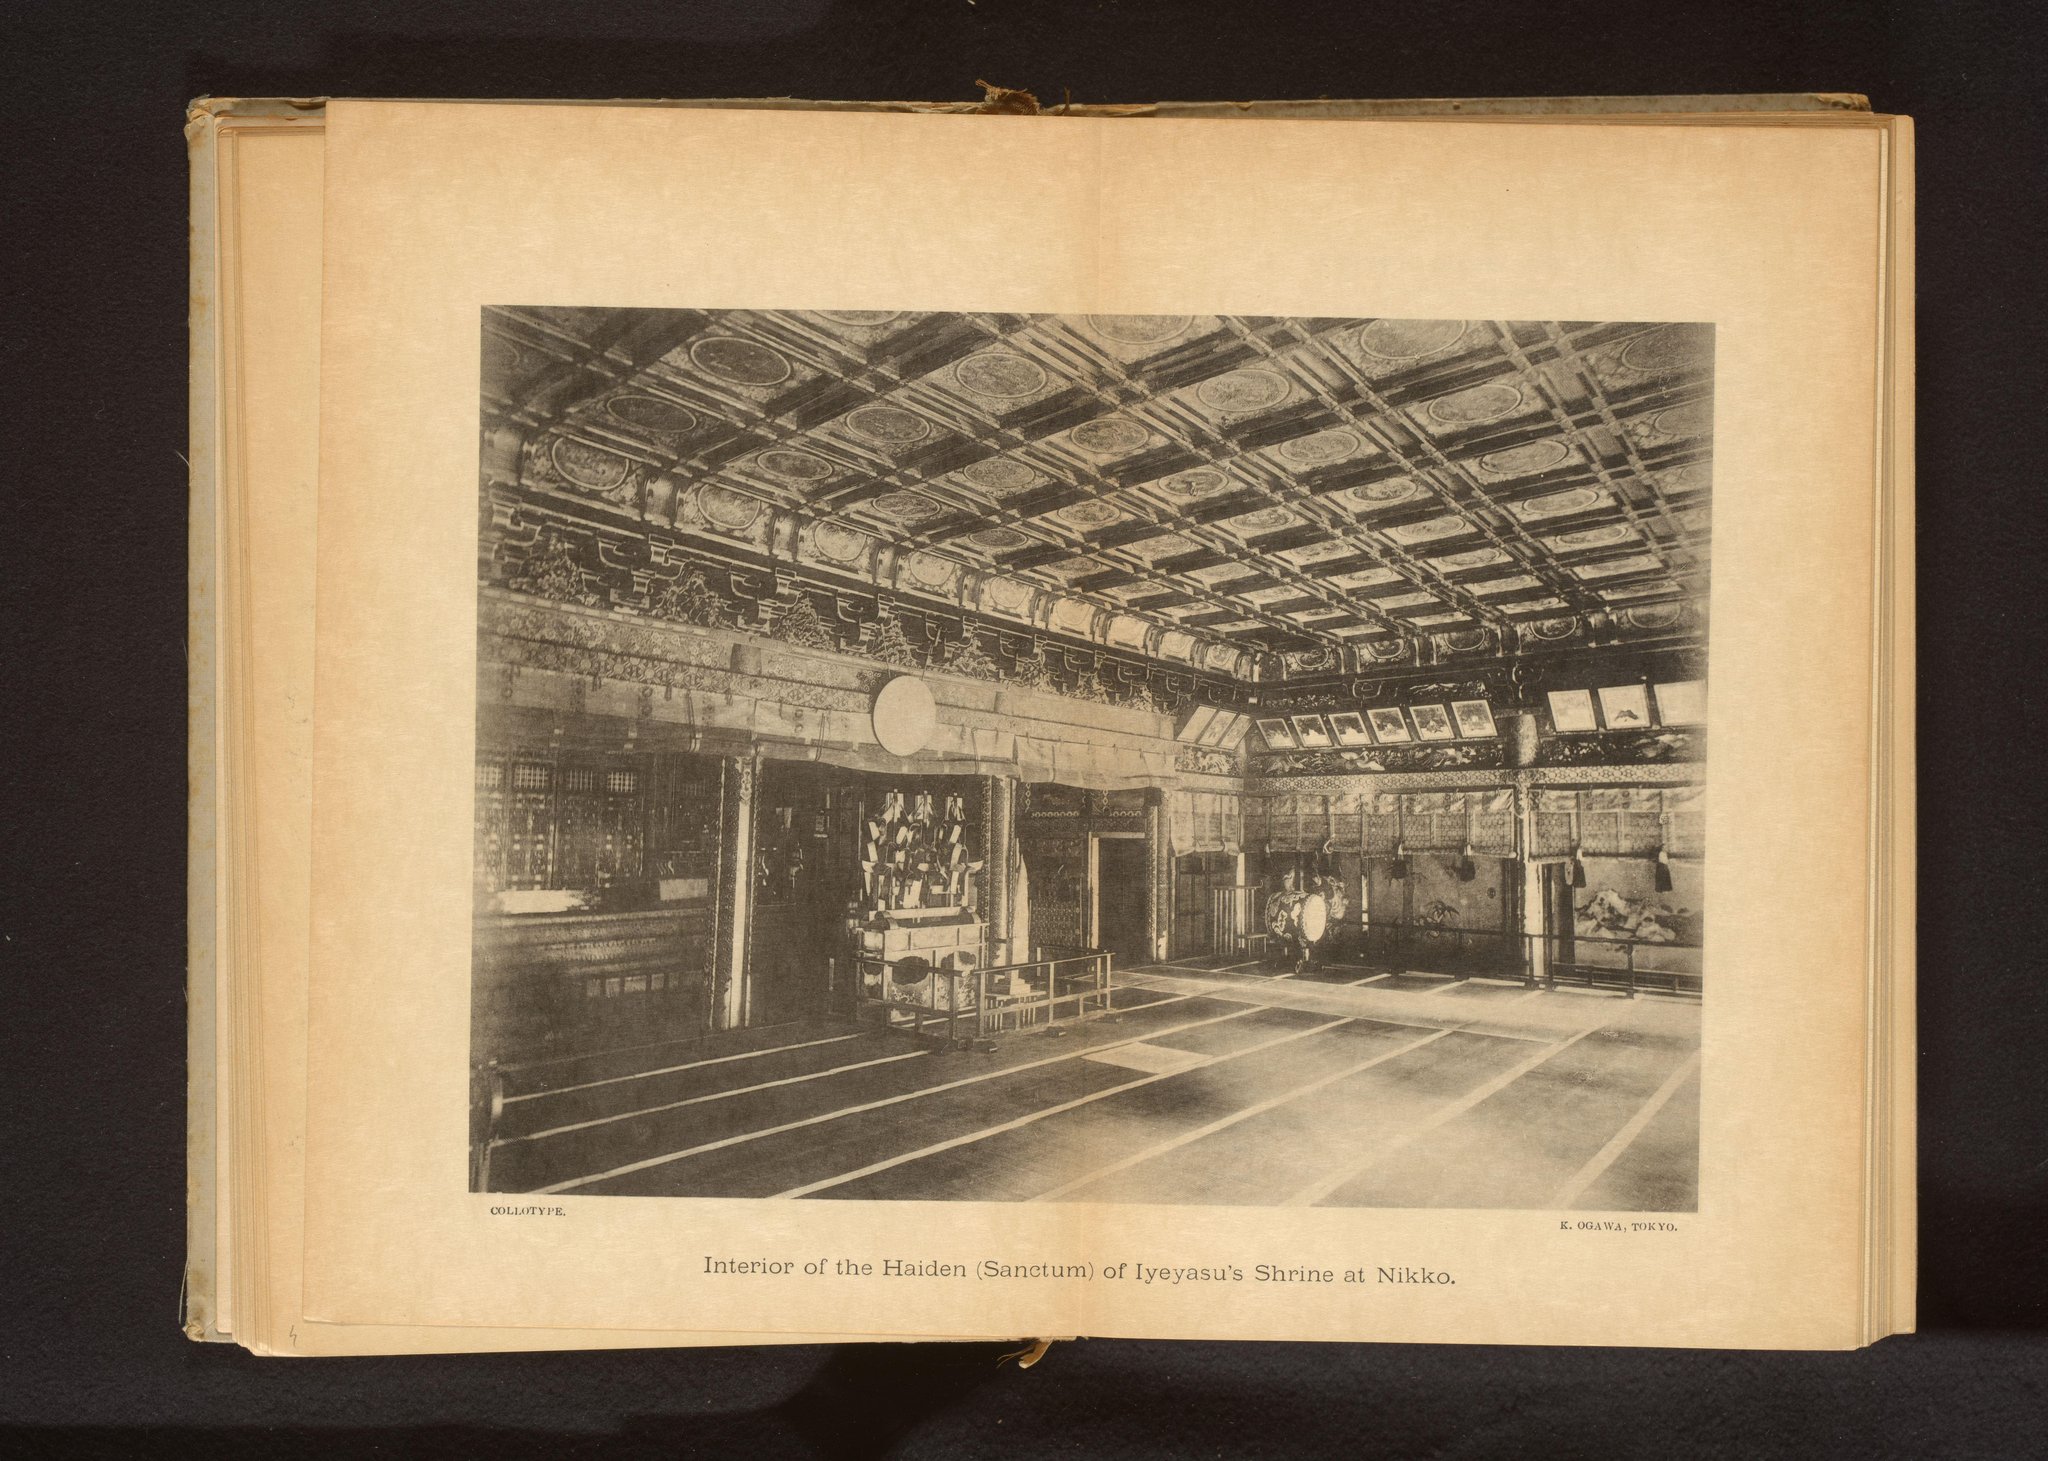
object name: page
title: Interior of the Haiden (Sanctum) of Iyeyasu's Shrine at Nikko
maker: kazumasa ogawa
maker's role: auteur, fotograaf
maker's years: 1860-1929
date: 1883-1893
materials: paper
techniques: photograph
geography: nikko toshogu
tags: temple, shrine ~ shinto, interior ~ representation of a building